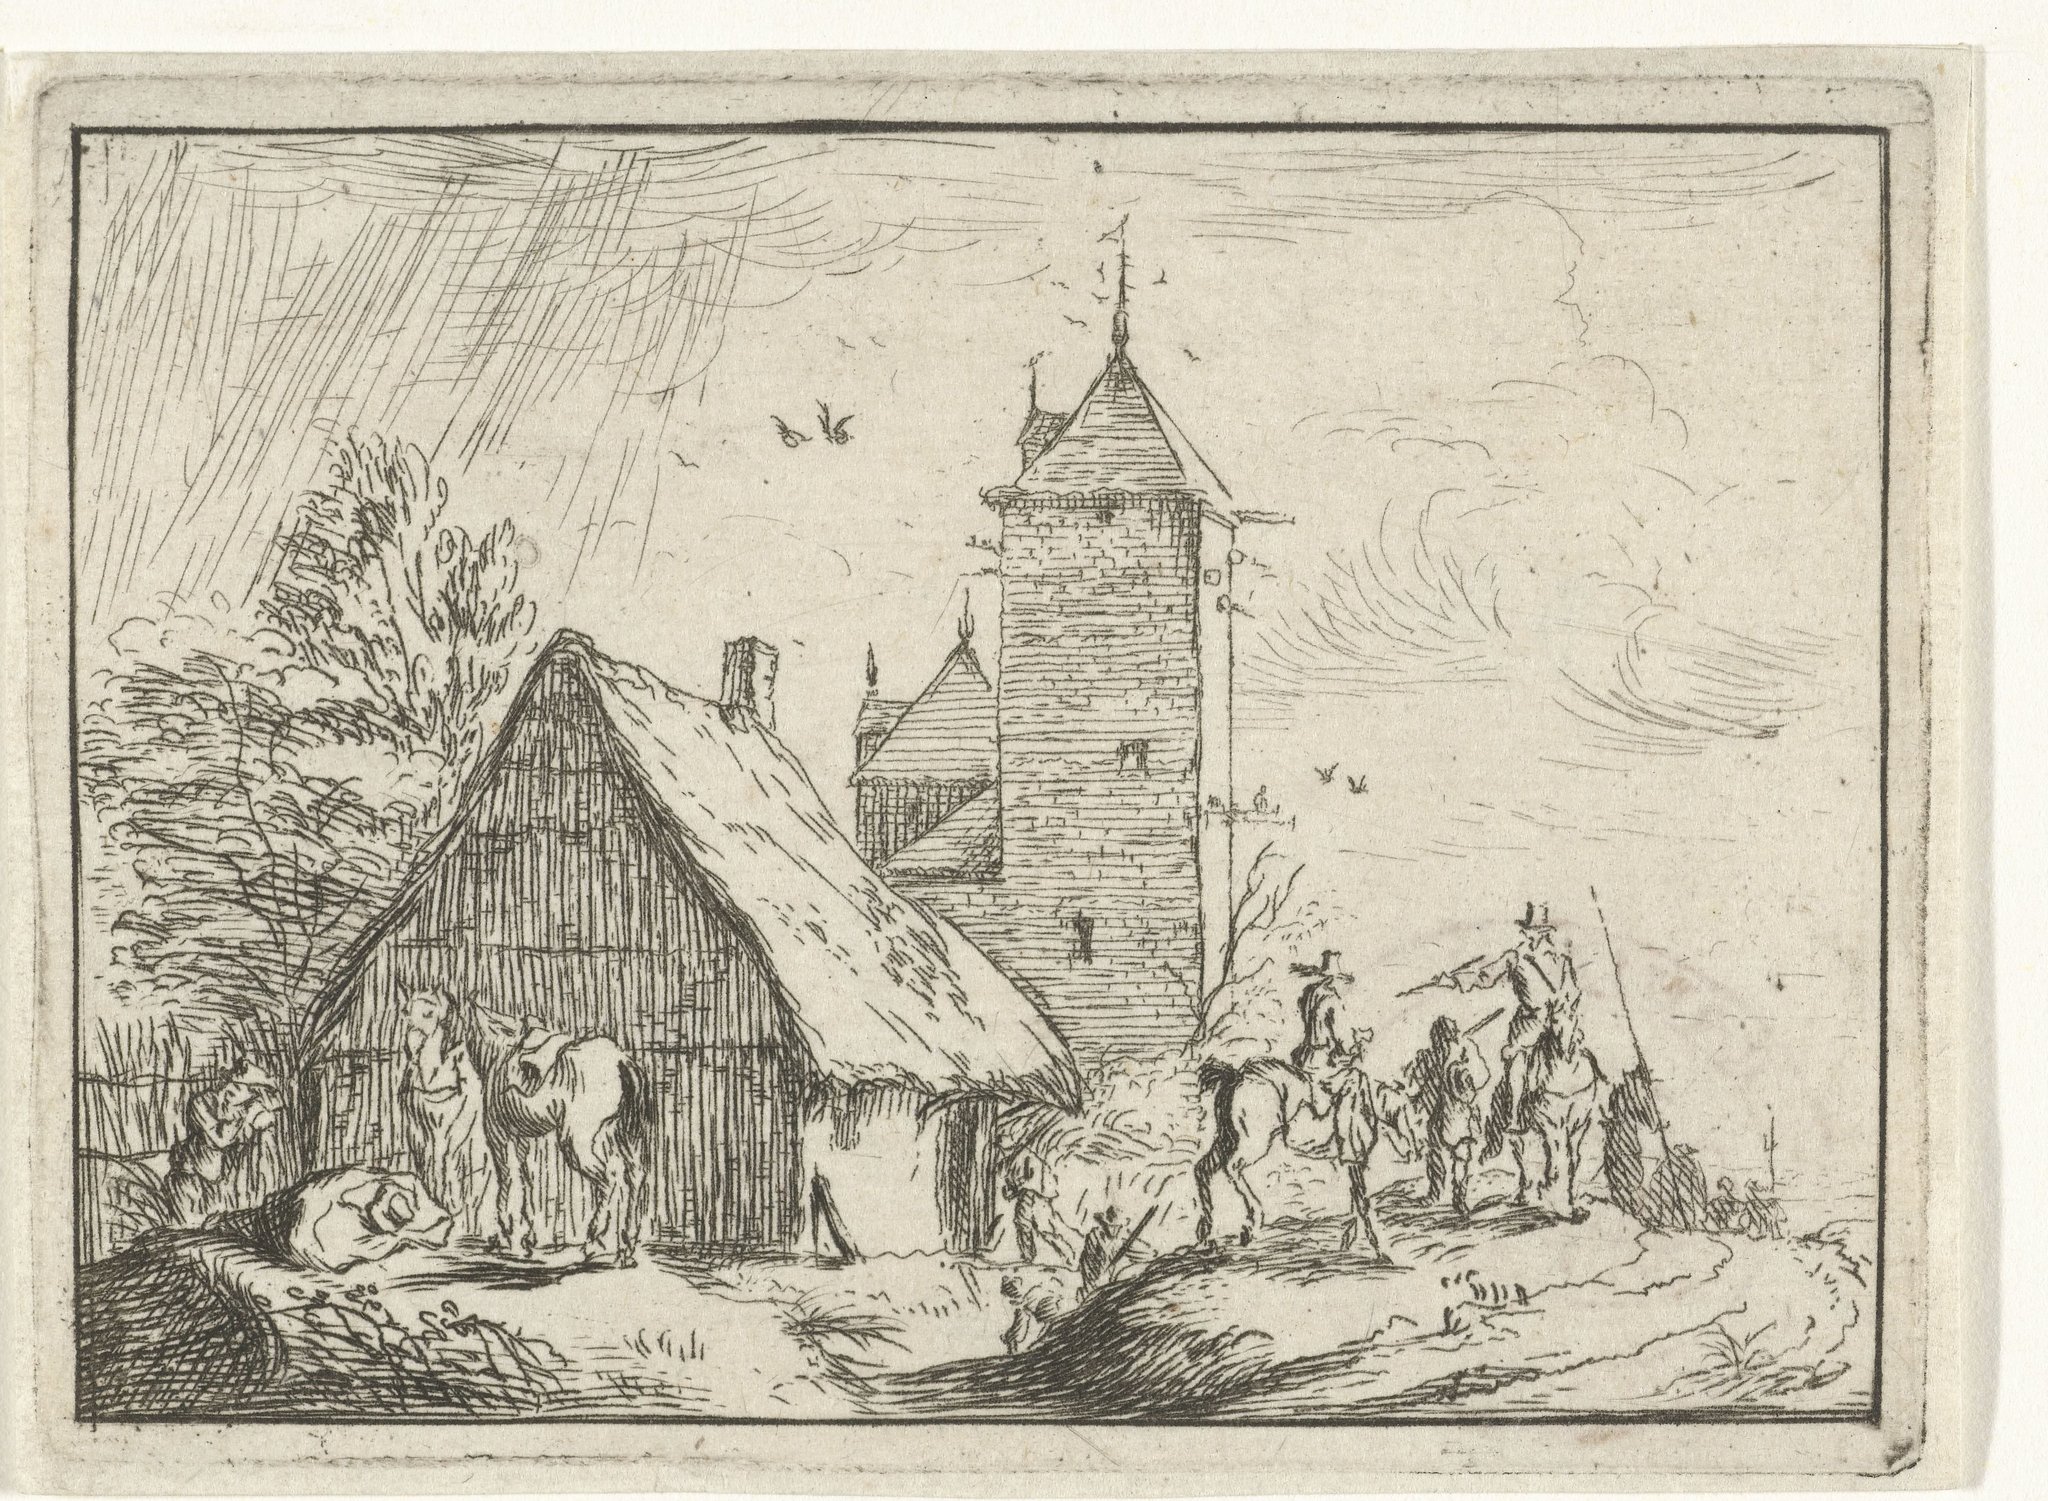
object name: print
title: Landschappen met kampementen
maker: robert van den hoecke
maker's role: draughtsman, painter, print maker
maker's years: 1622-1668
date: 1632-1668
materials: paper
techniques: etching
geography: southern netherlands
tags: riding a horse, ass, or mule; rider, horseman, landscape with tower or castle (+ city(-scape) with figures, staffage)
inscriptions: collector's mark: Lugt 240